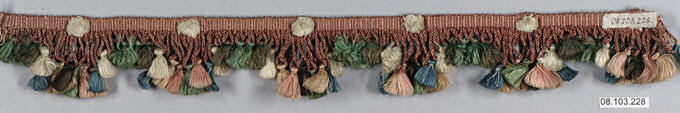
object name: fringe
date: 1701-1733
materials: silk